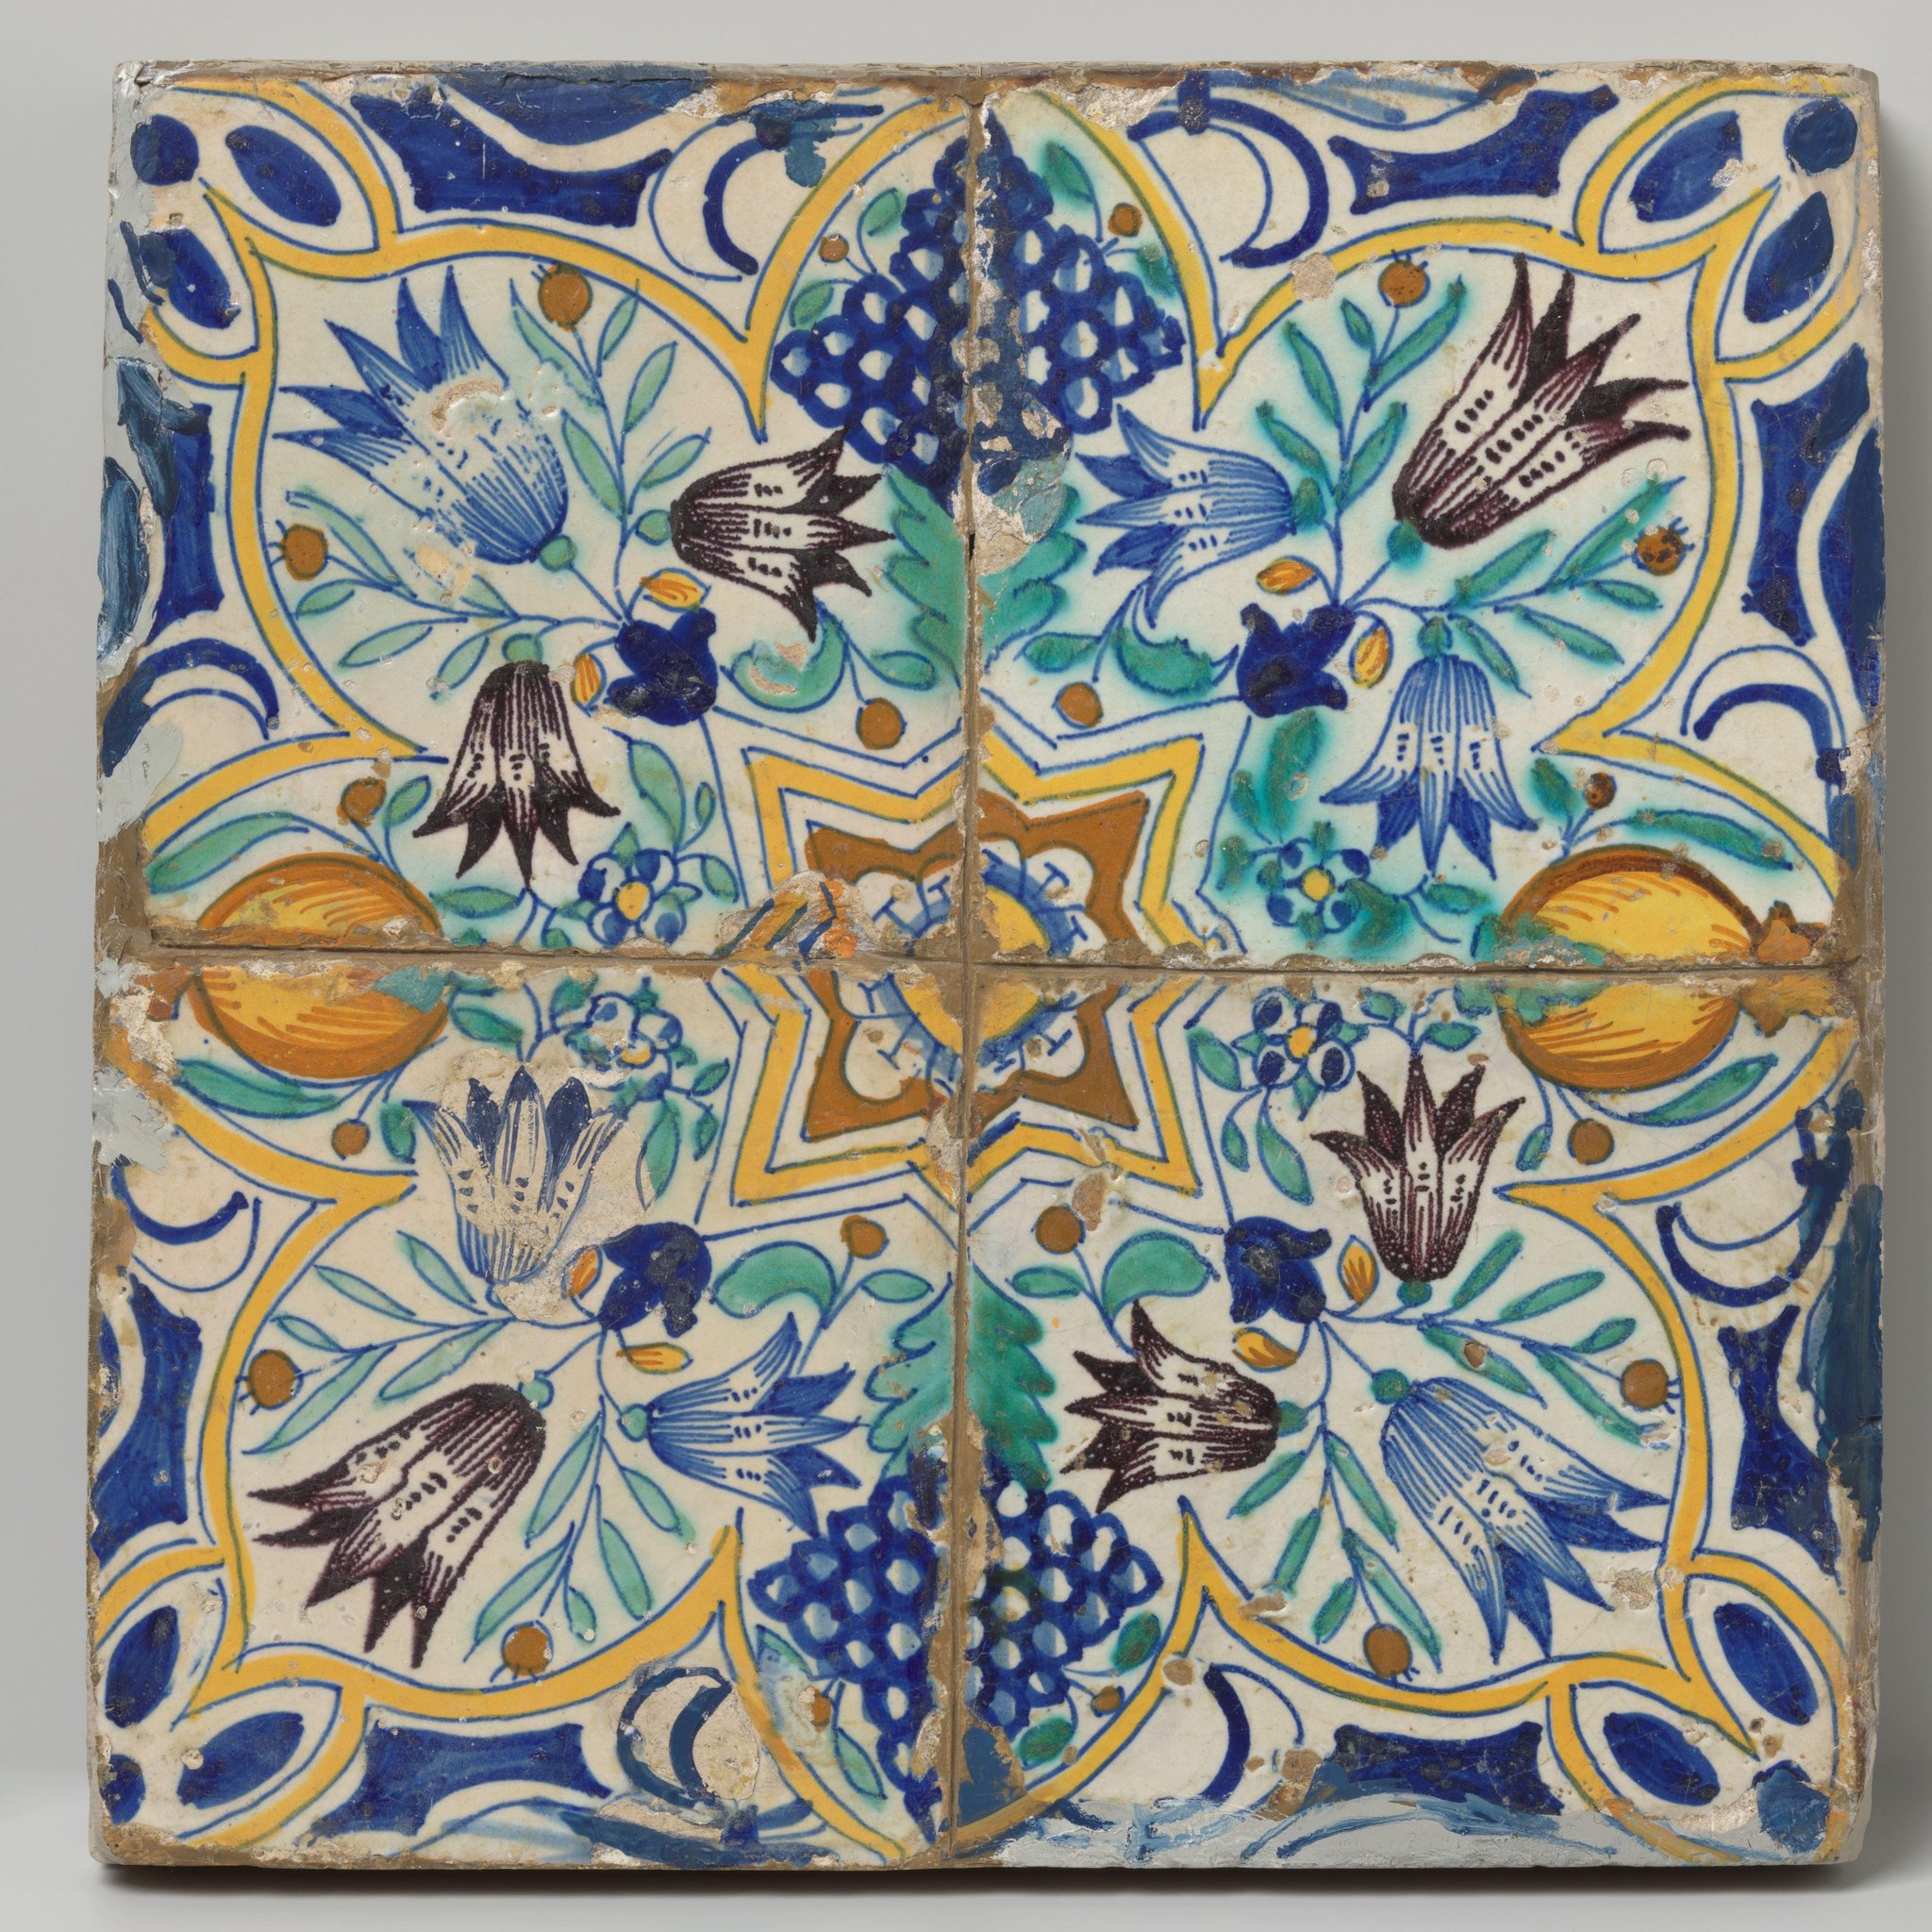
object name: stertegel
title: Vier tegels die samen een ster vormen omgeven door tulpen, druiventrossen en granaatappels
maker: Anonymous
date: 1600-1625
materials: earthenware, glaze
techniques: maiolica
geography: netherlands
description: Vier tegels (2 x 2) met een veelkleurig (blauw, groen, oranje, geel en paars) geschilderde voorstelling. Samen vormen zij in het midden een ster omgeven door tulpen, druiventrossen en granaatappels binnen een dubbele vierpas.